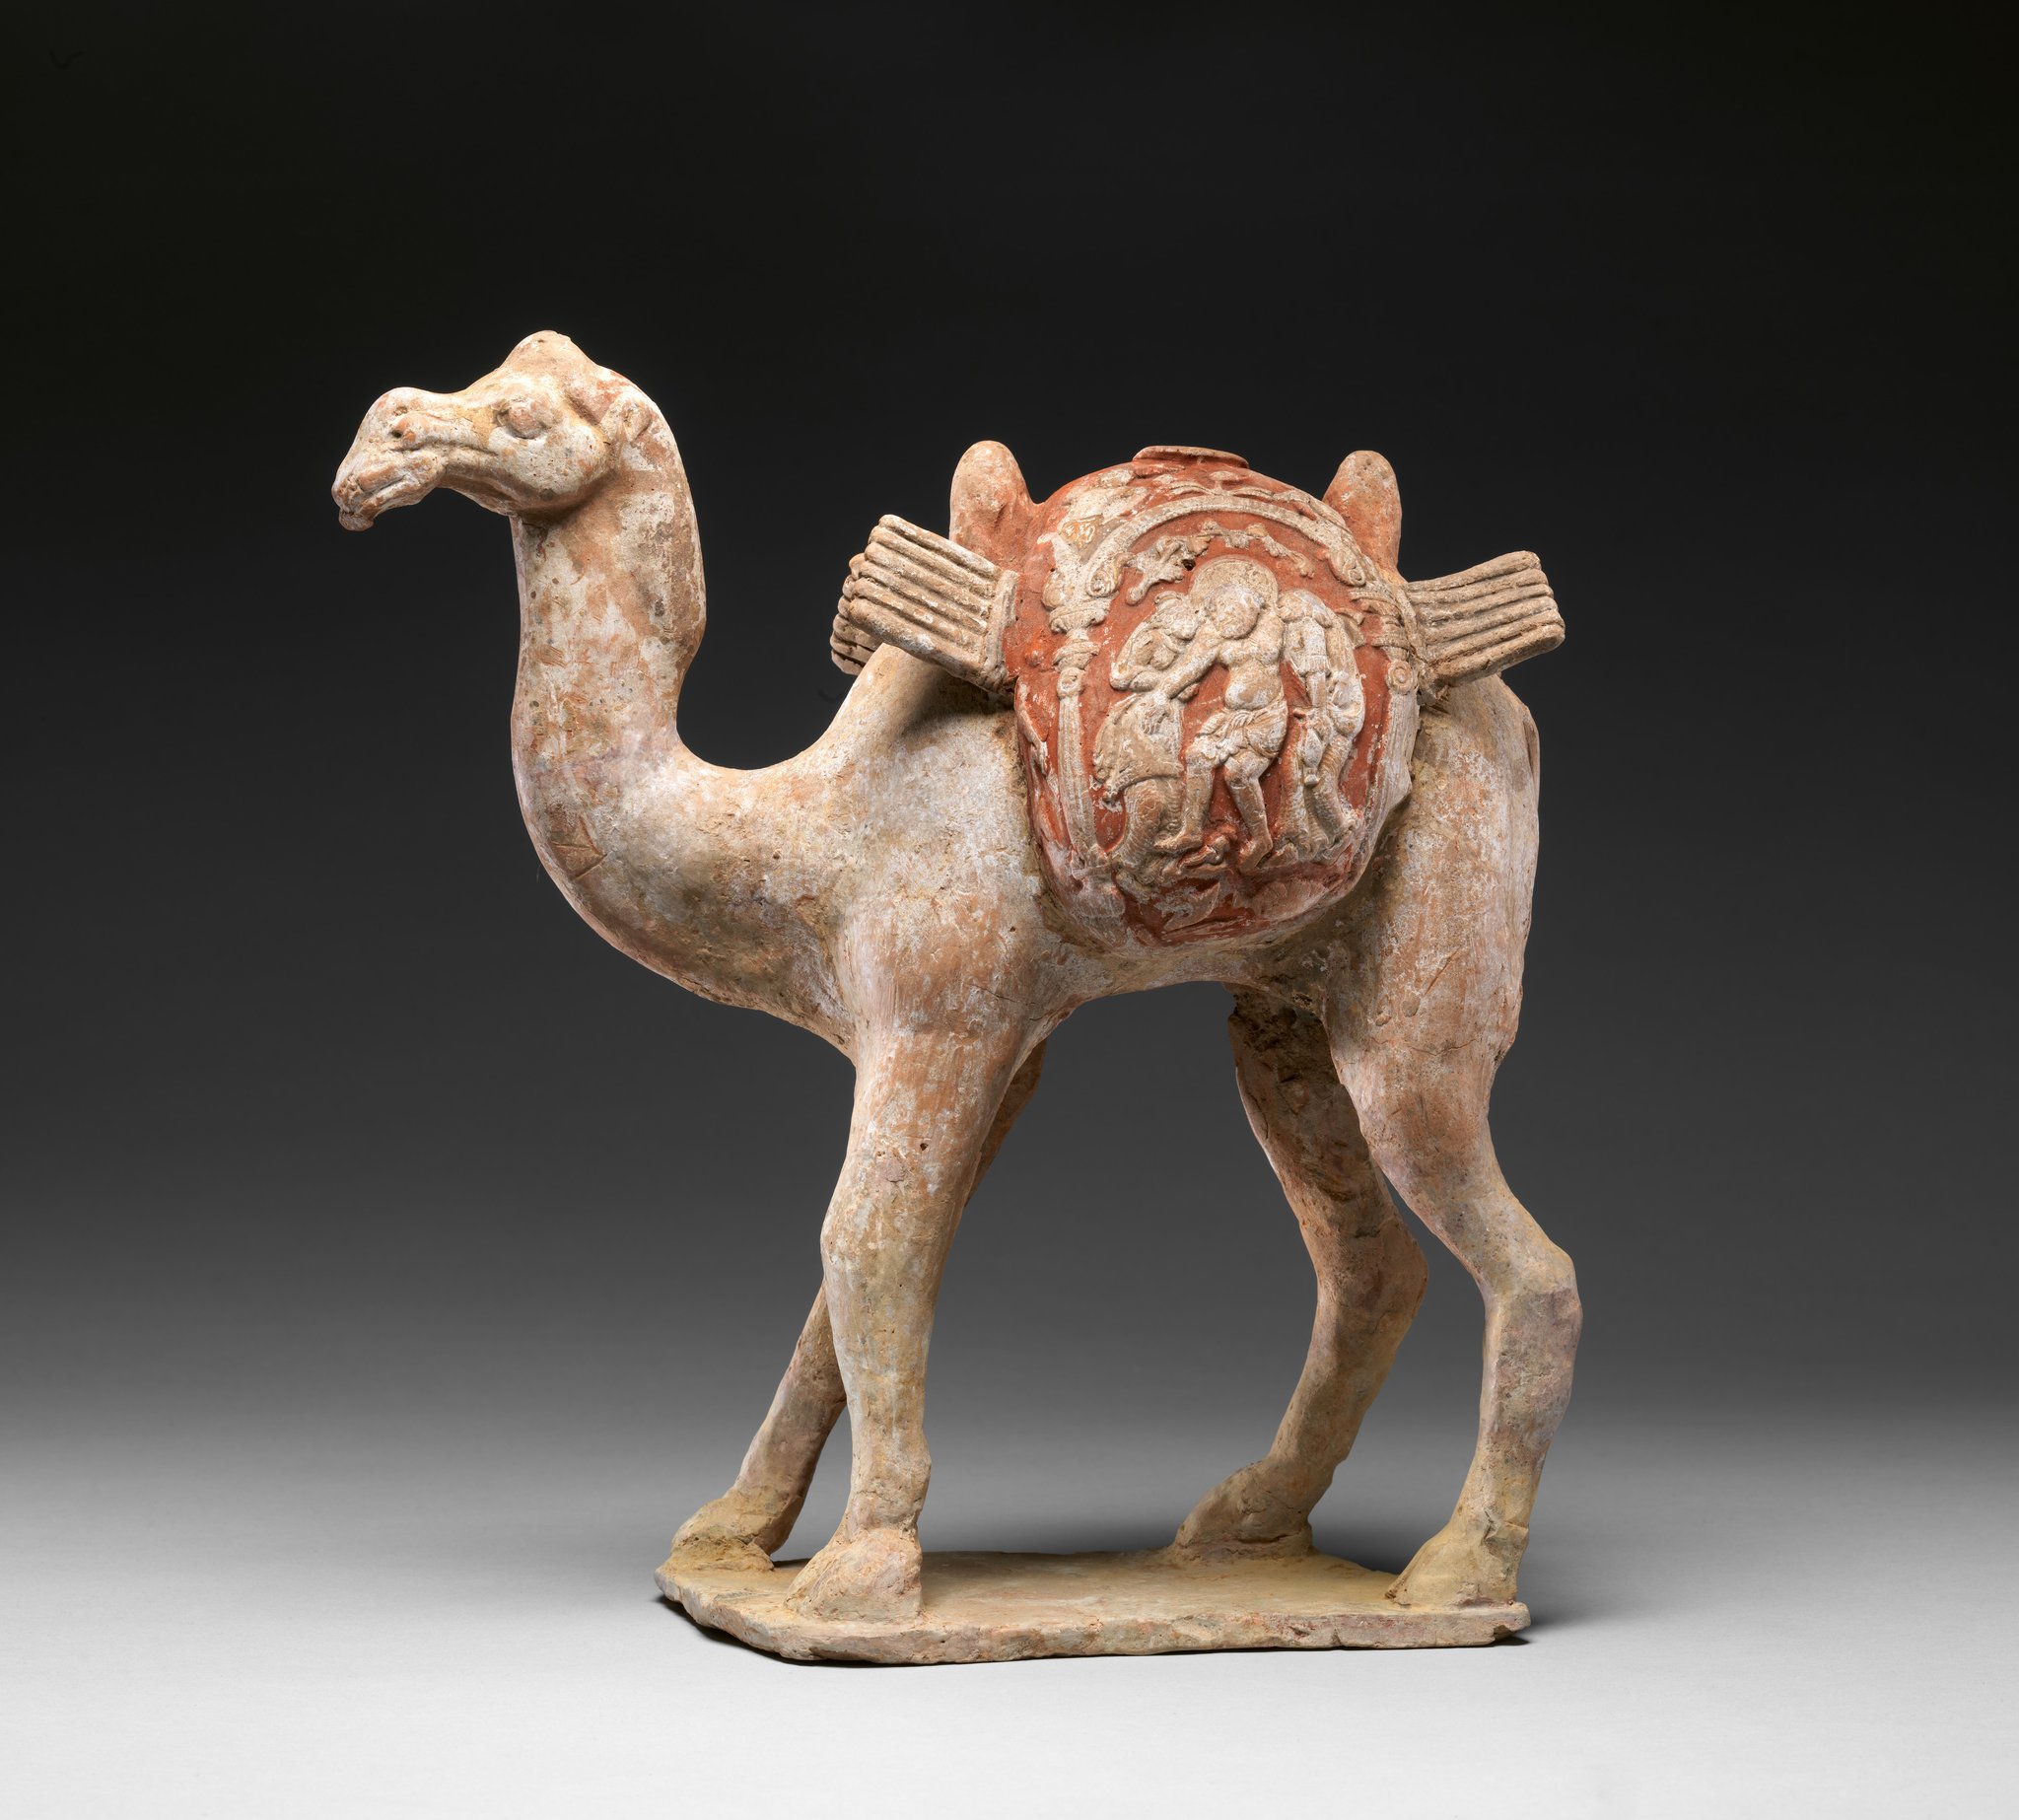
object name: tomb figure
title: Camel with Dionysian imagery on its saddle bags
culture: chinese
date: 567-700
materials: earthenware, pigment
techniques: appliqué, relief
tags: camels